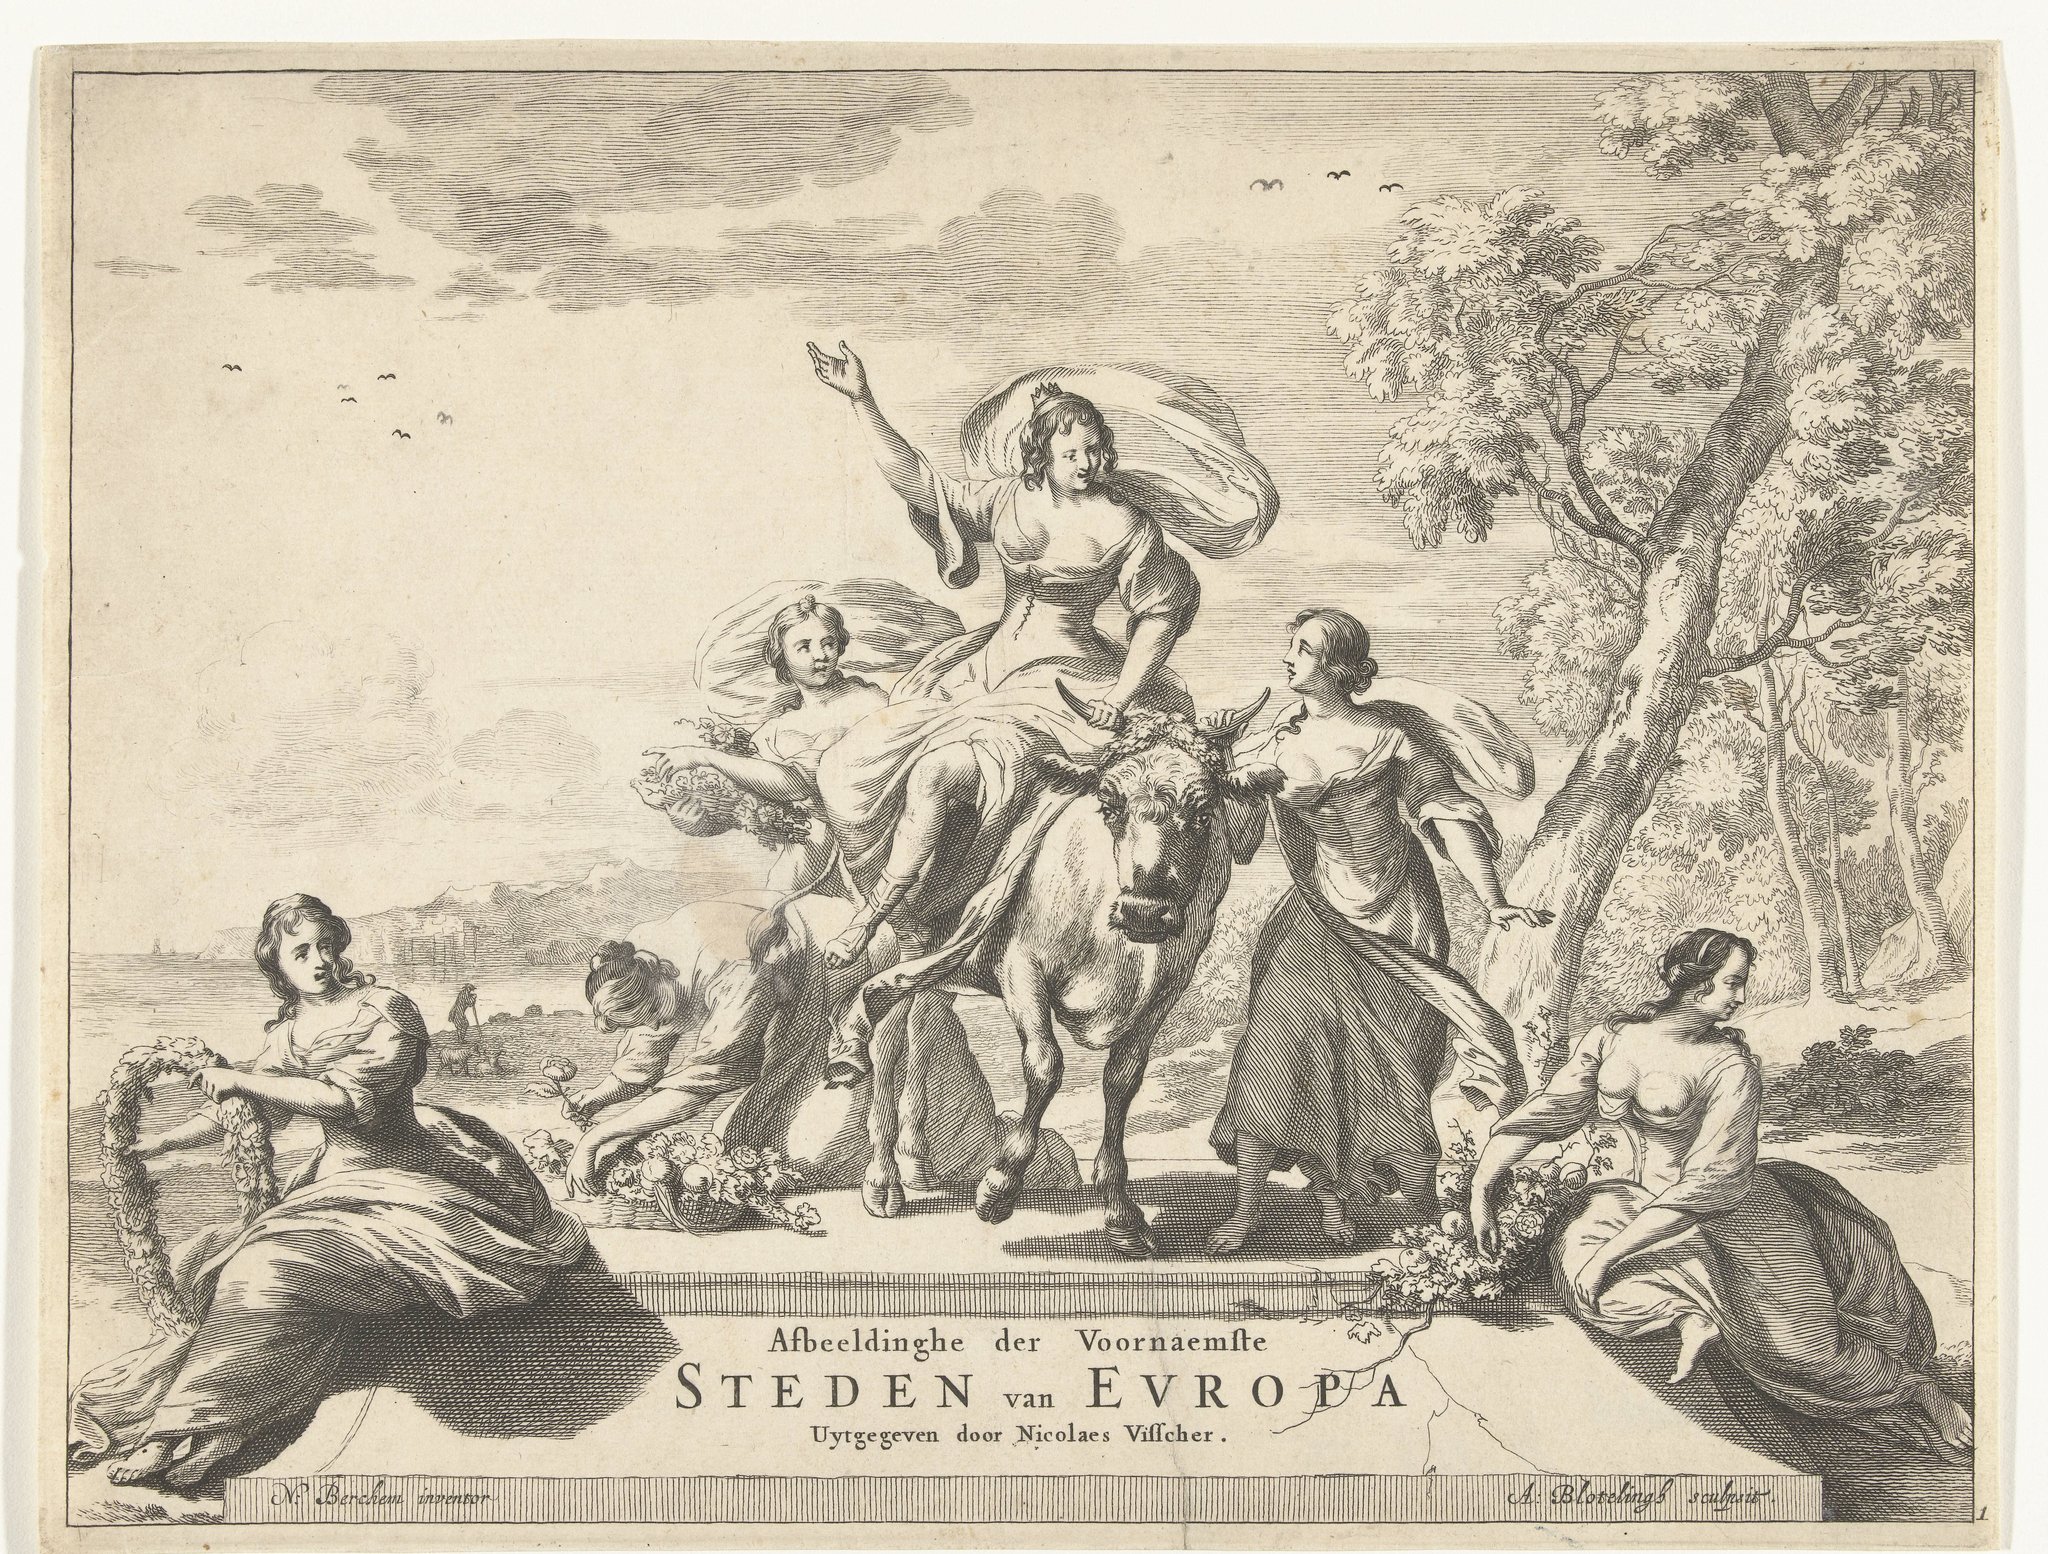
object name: print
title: Europa en de stier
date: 1655-1690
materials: paper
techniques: engraving, etching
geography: amsterdam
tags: europa and her maidens play with the bull, and/or adorn it with flowers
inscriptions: collector's mark: Lugt 240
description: Europa rijdt aan het strand op de stier. Haar dienstmaagden zijn bezig de stier met bloemguirlandes te versieren.